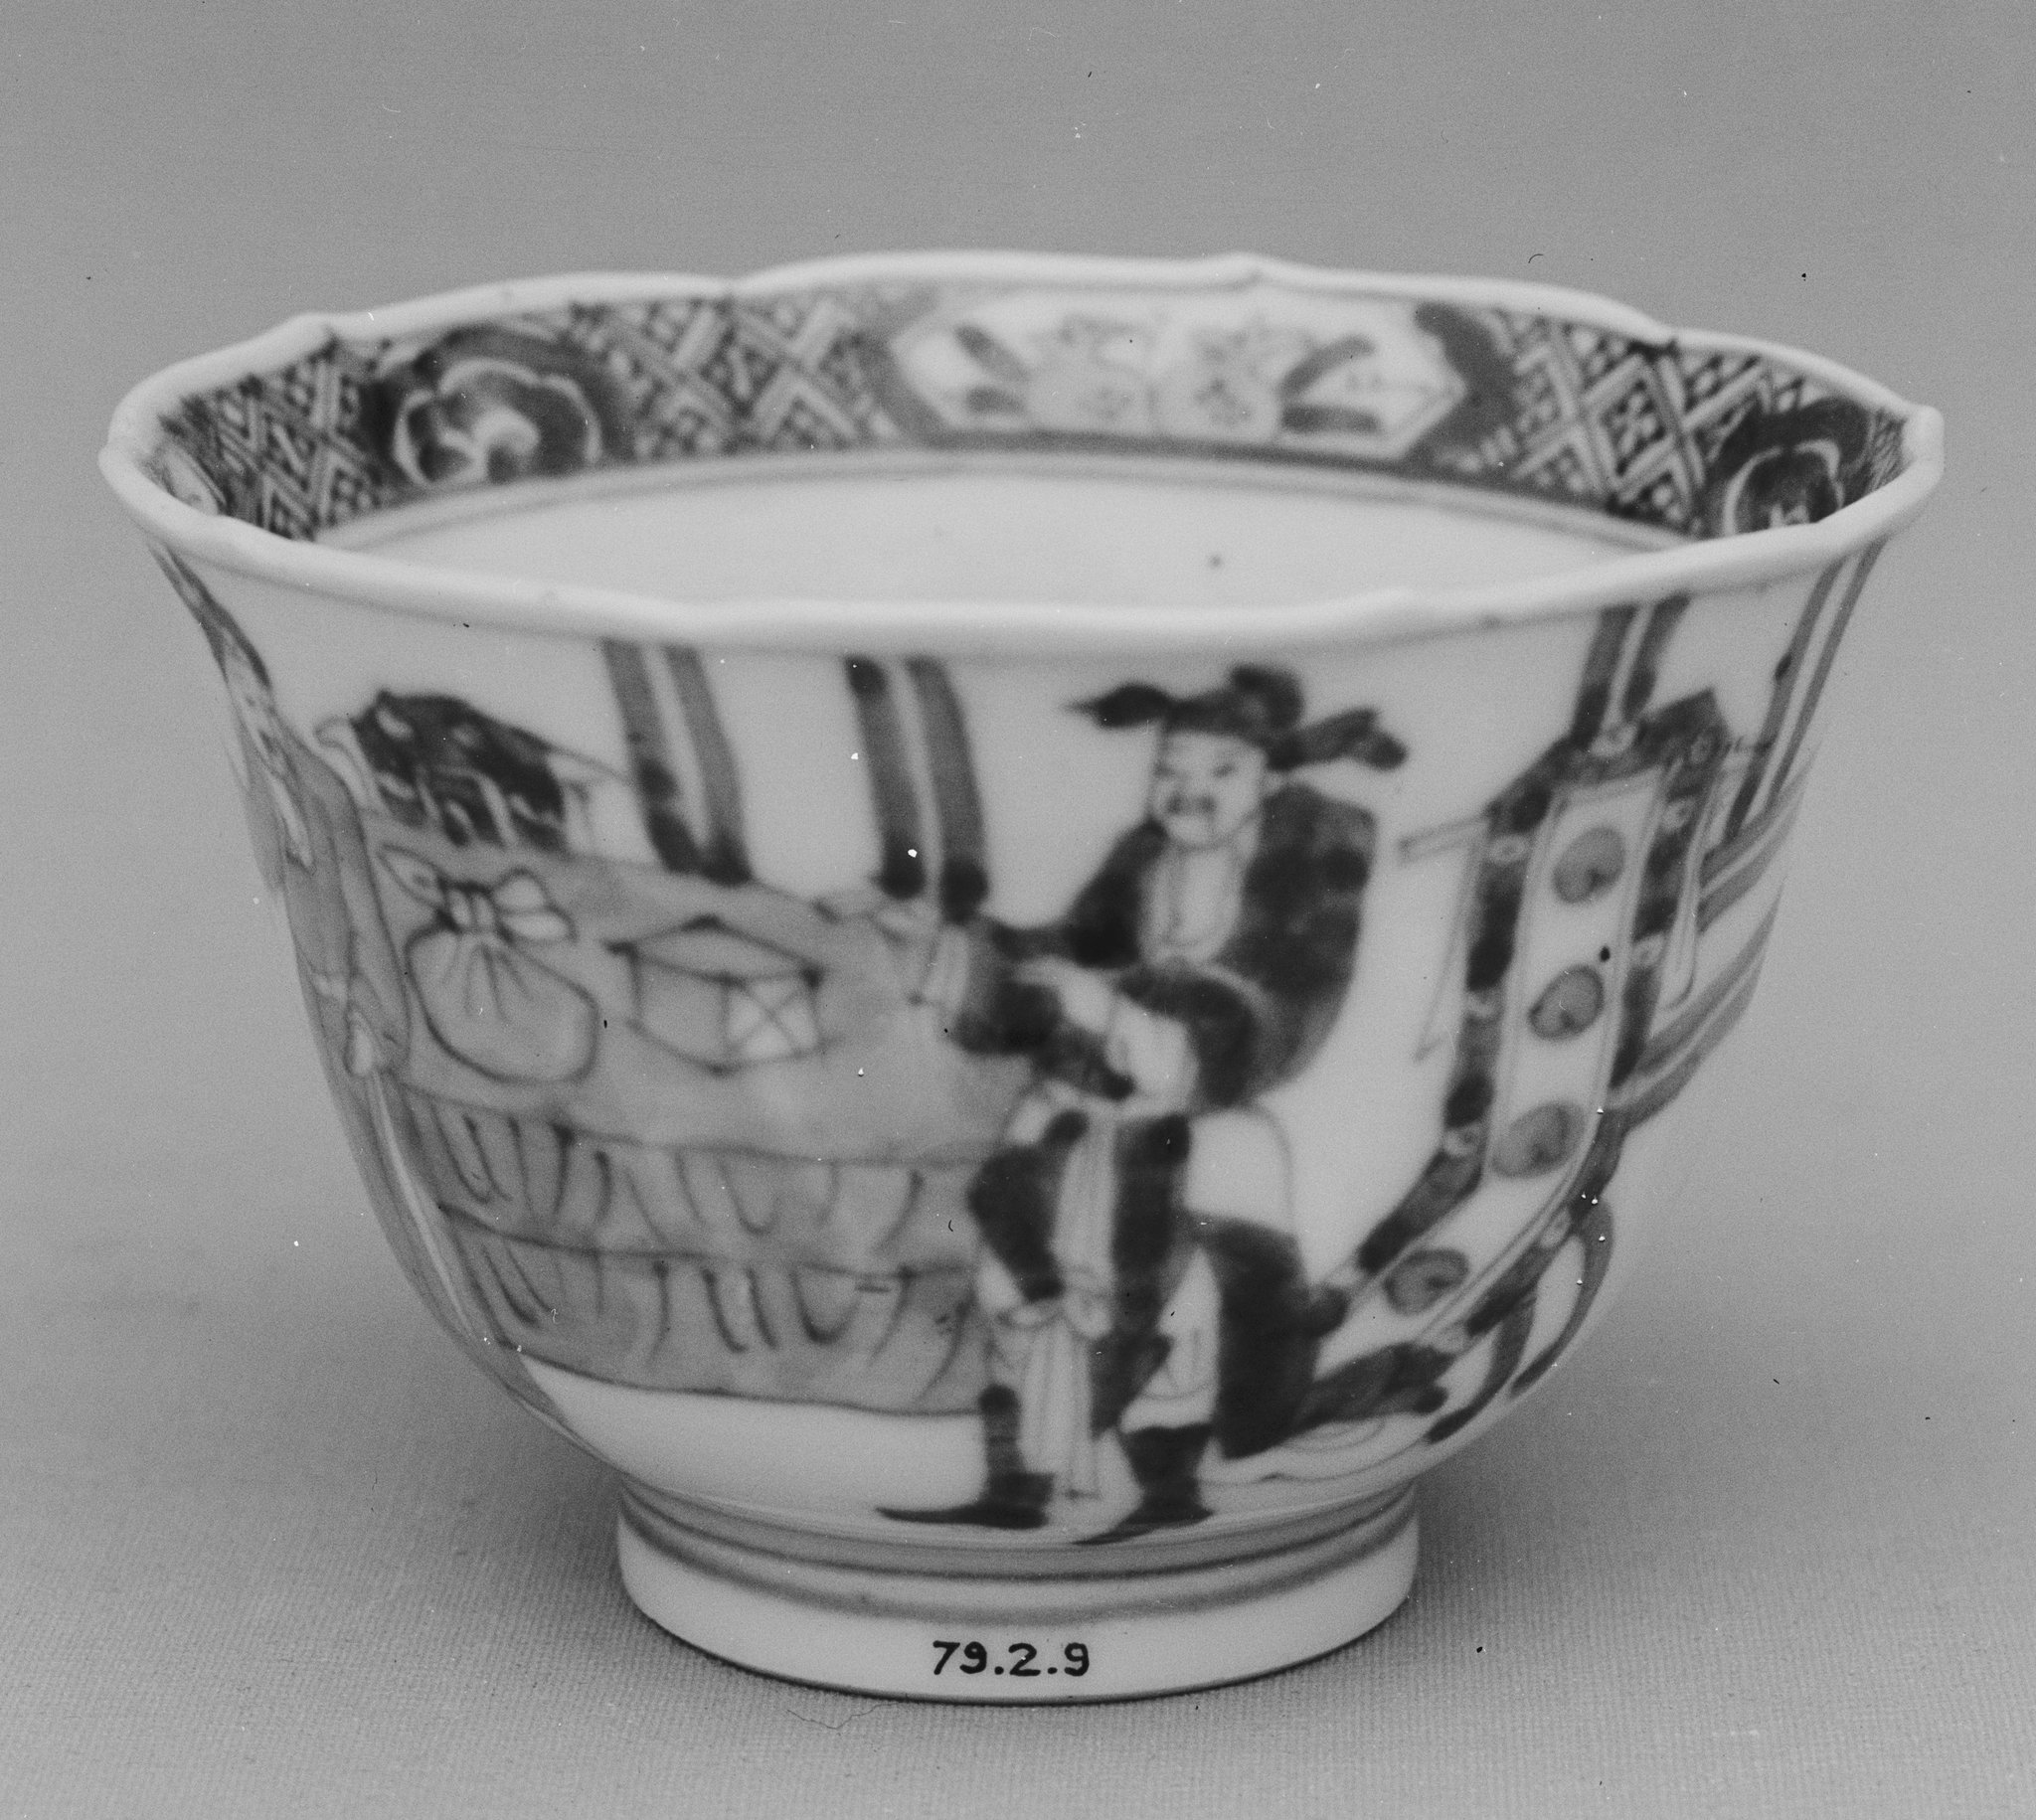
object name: cup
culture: chinese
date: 1701-1733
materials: porcelain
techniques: painting, underglaze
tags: men